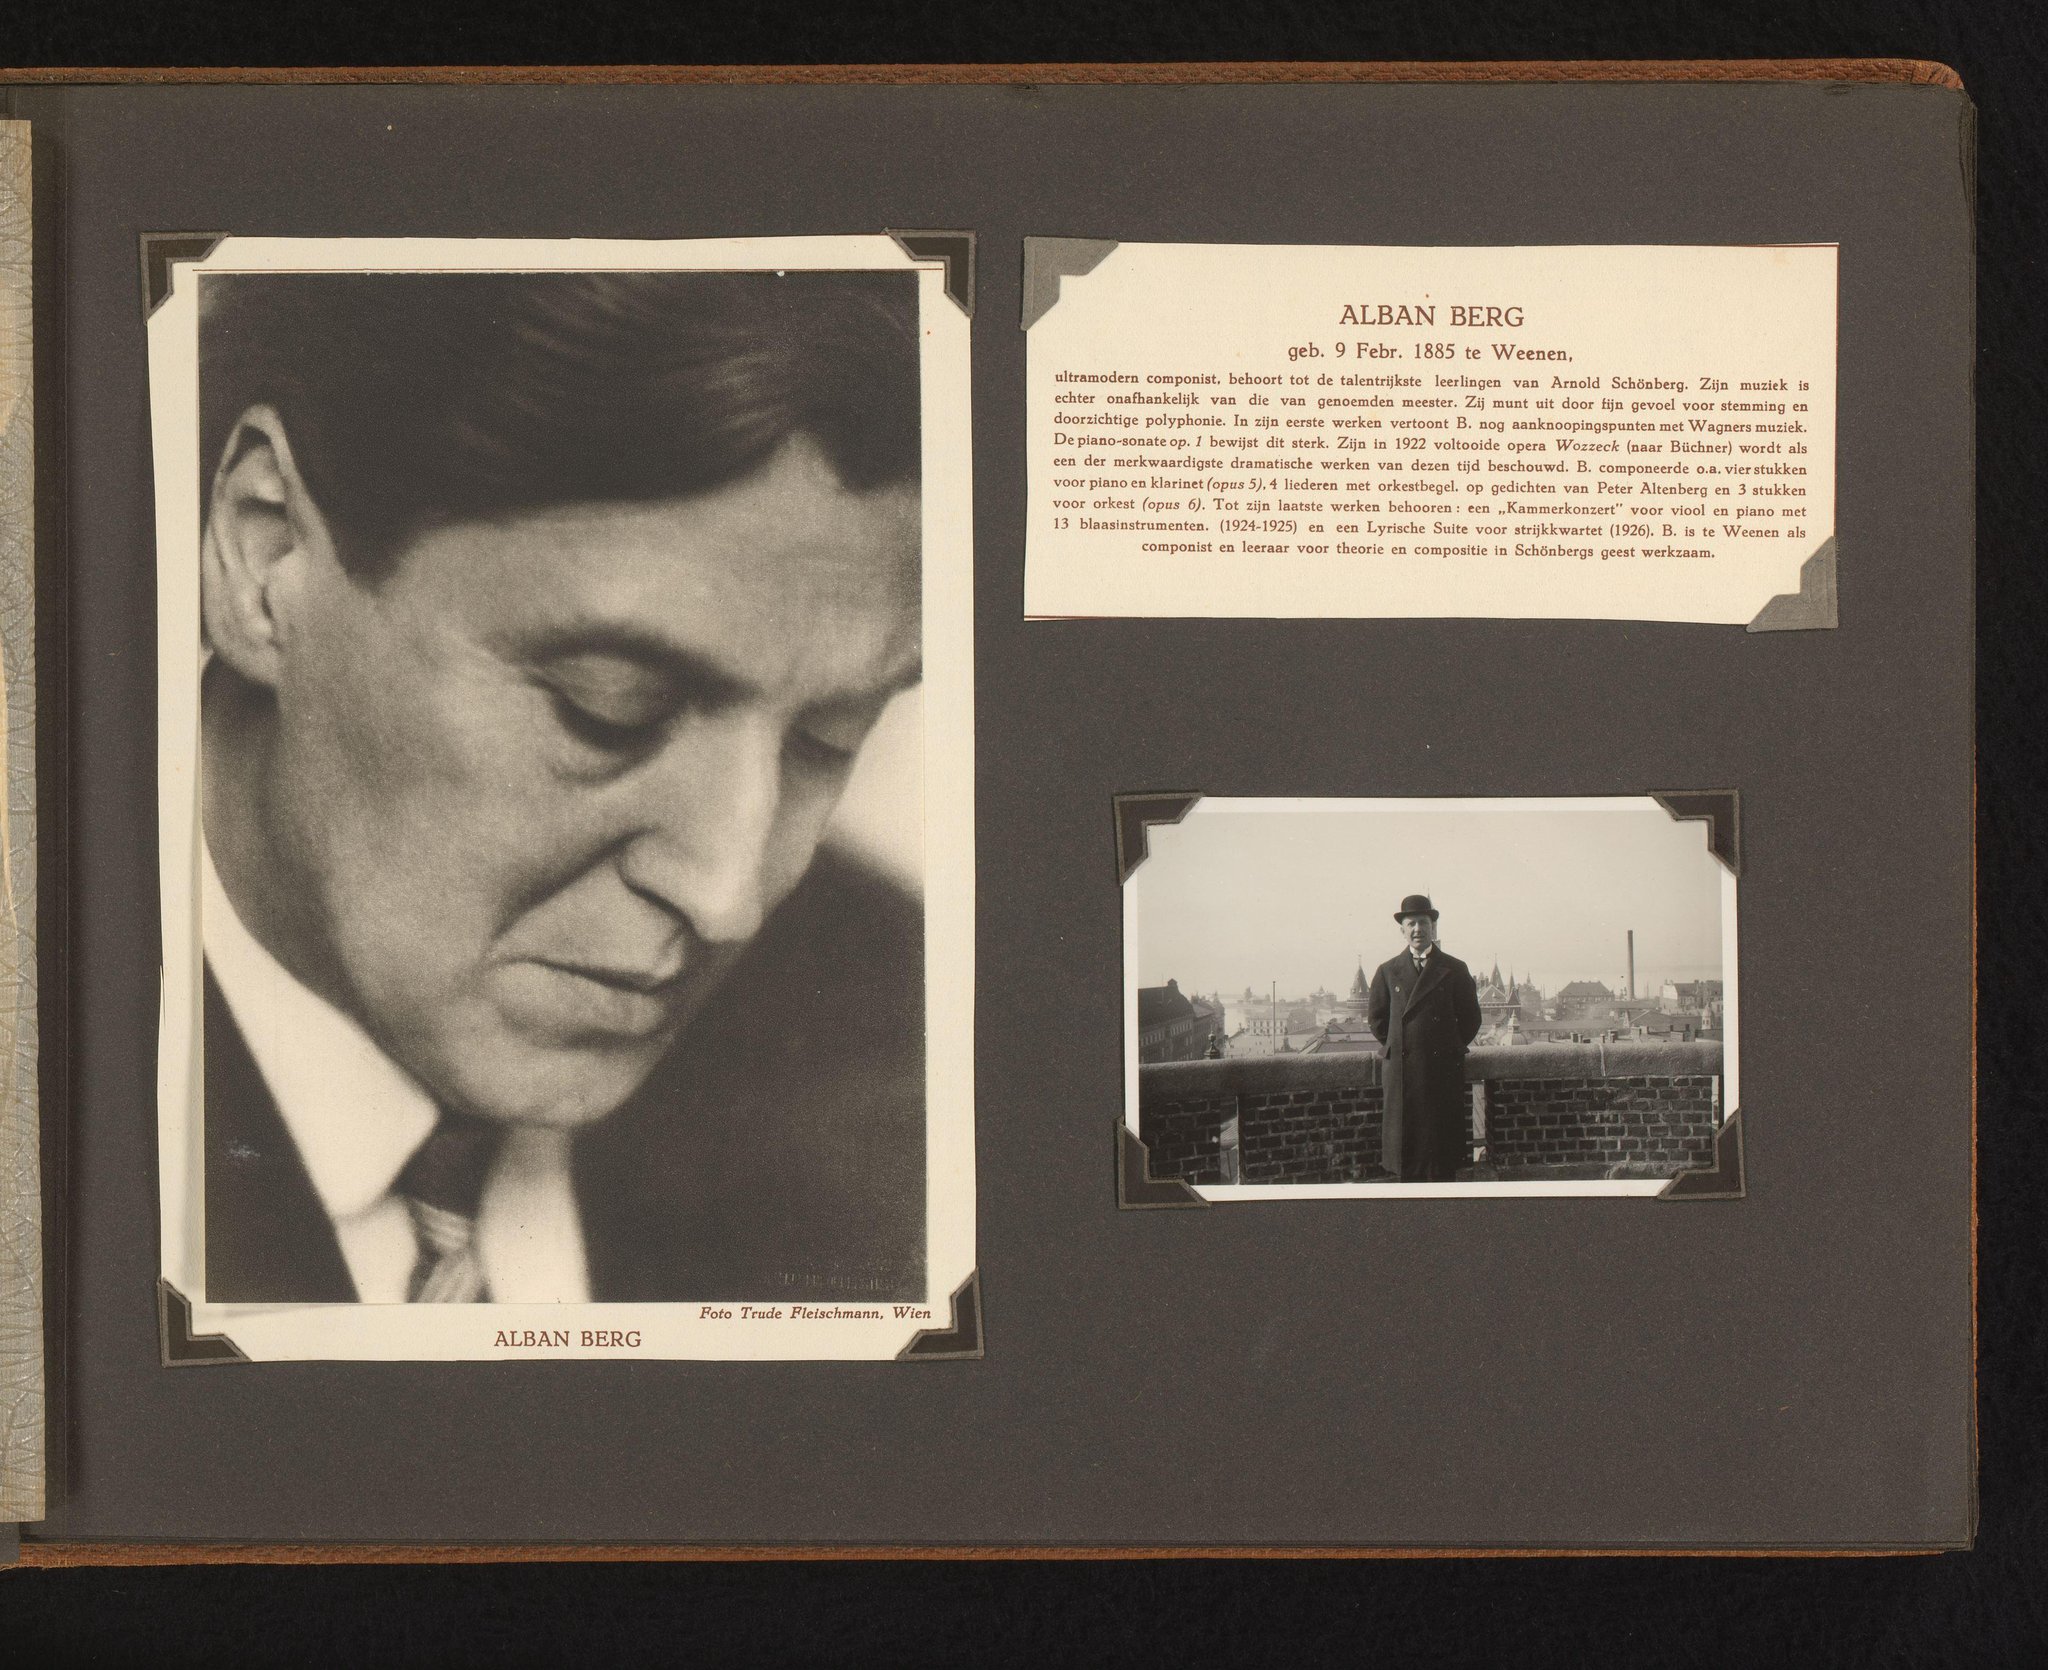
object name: album leaf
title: Alban Berg en Helsingborg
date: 1933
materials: paper, photographic support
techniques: gelatin silver print, rotogravure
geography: helsingborg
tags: portrait of composer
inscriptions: inscription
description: Albumblad met een portret van en een tekst over de componist Alban Berg en een foto uit 1933 van een man in Helsingborg (op verso tekst in Esperanto). Onderdeel van het Esperanto album uit ca. 1933-1936.